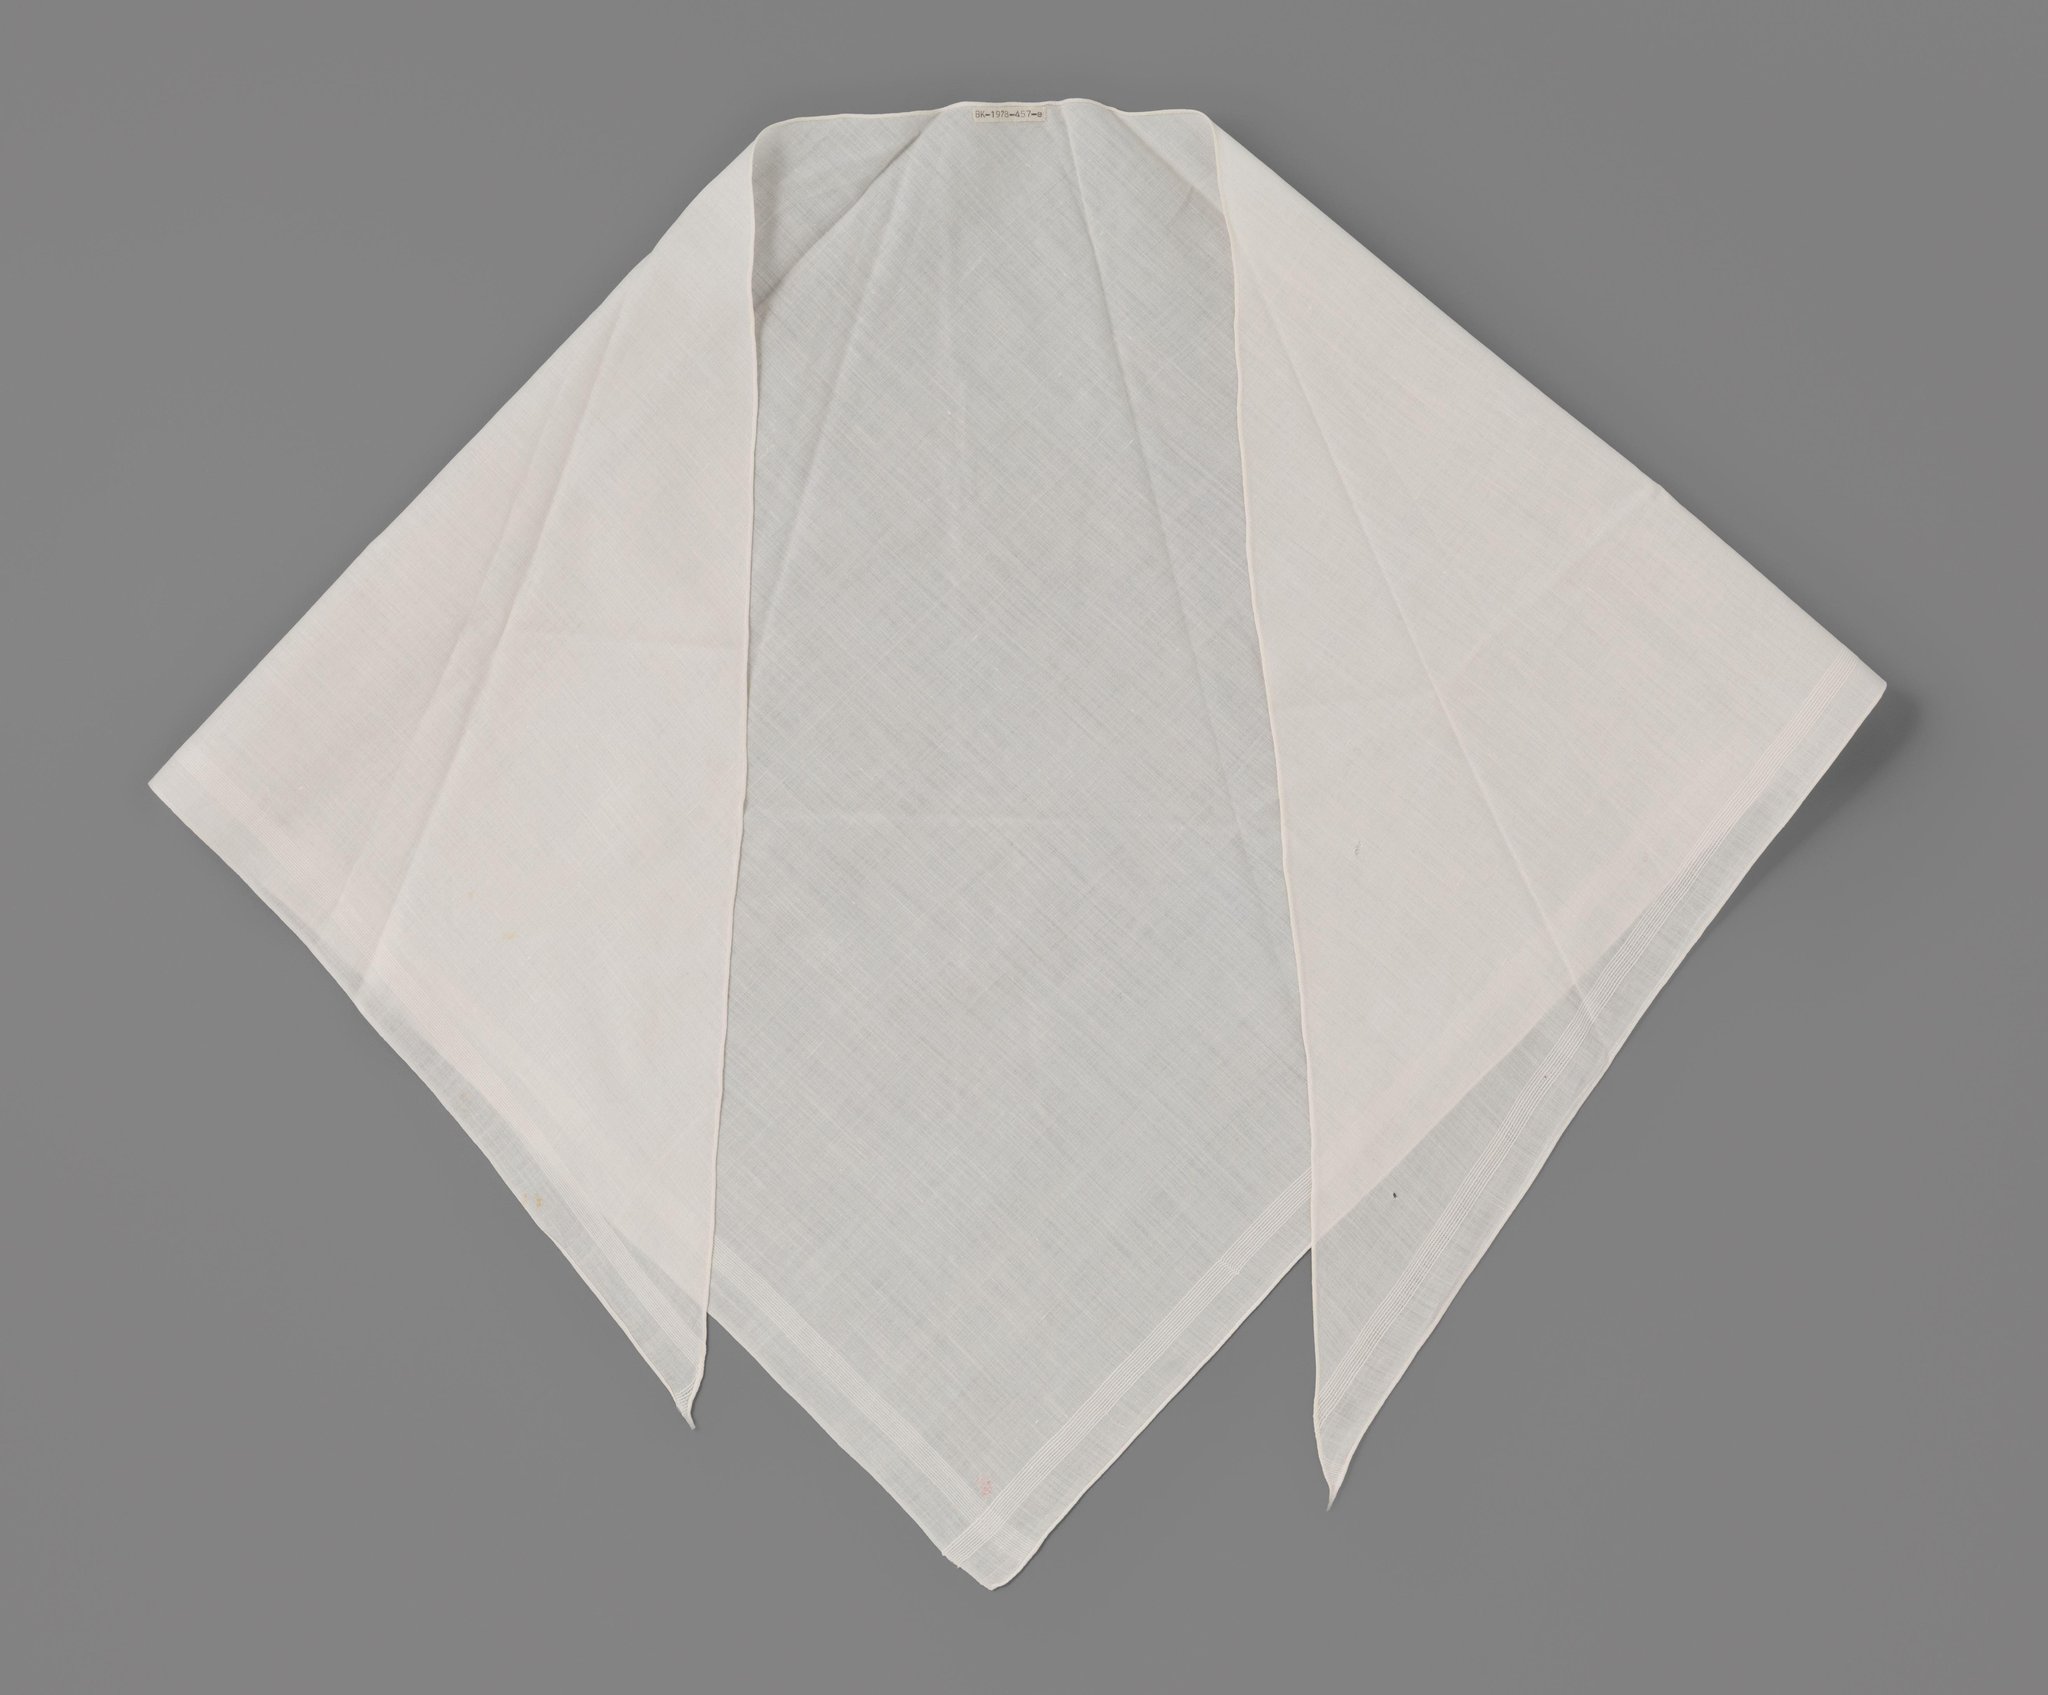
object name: fichu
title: Fichu van katoen, driehoekig, met rond rand van dikke streepbiezen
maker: Anonymous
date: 1890-1900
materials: cotton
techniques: cross stitching, embroidered, weave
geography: amsterdam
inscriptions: mark: ‘NS/ 24’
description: Fichu van katoen, driehoekig, met rond rand van dikke streepbiezen. Model: een zijde zelfkant, overige twee zijden platte zoom. Schuin op de draad gewerkt. In de punt met kleine rode kruissteken gemerkt 'NS/ 24' voor mevrouw H.M.A.F. (Nine) Six-Bosch Reitz.